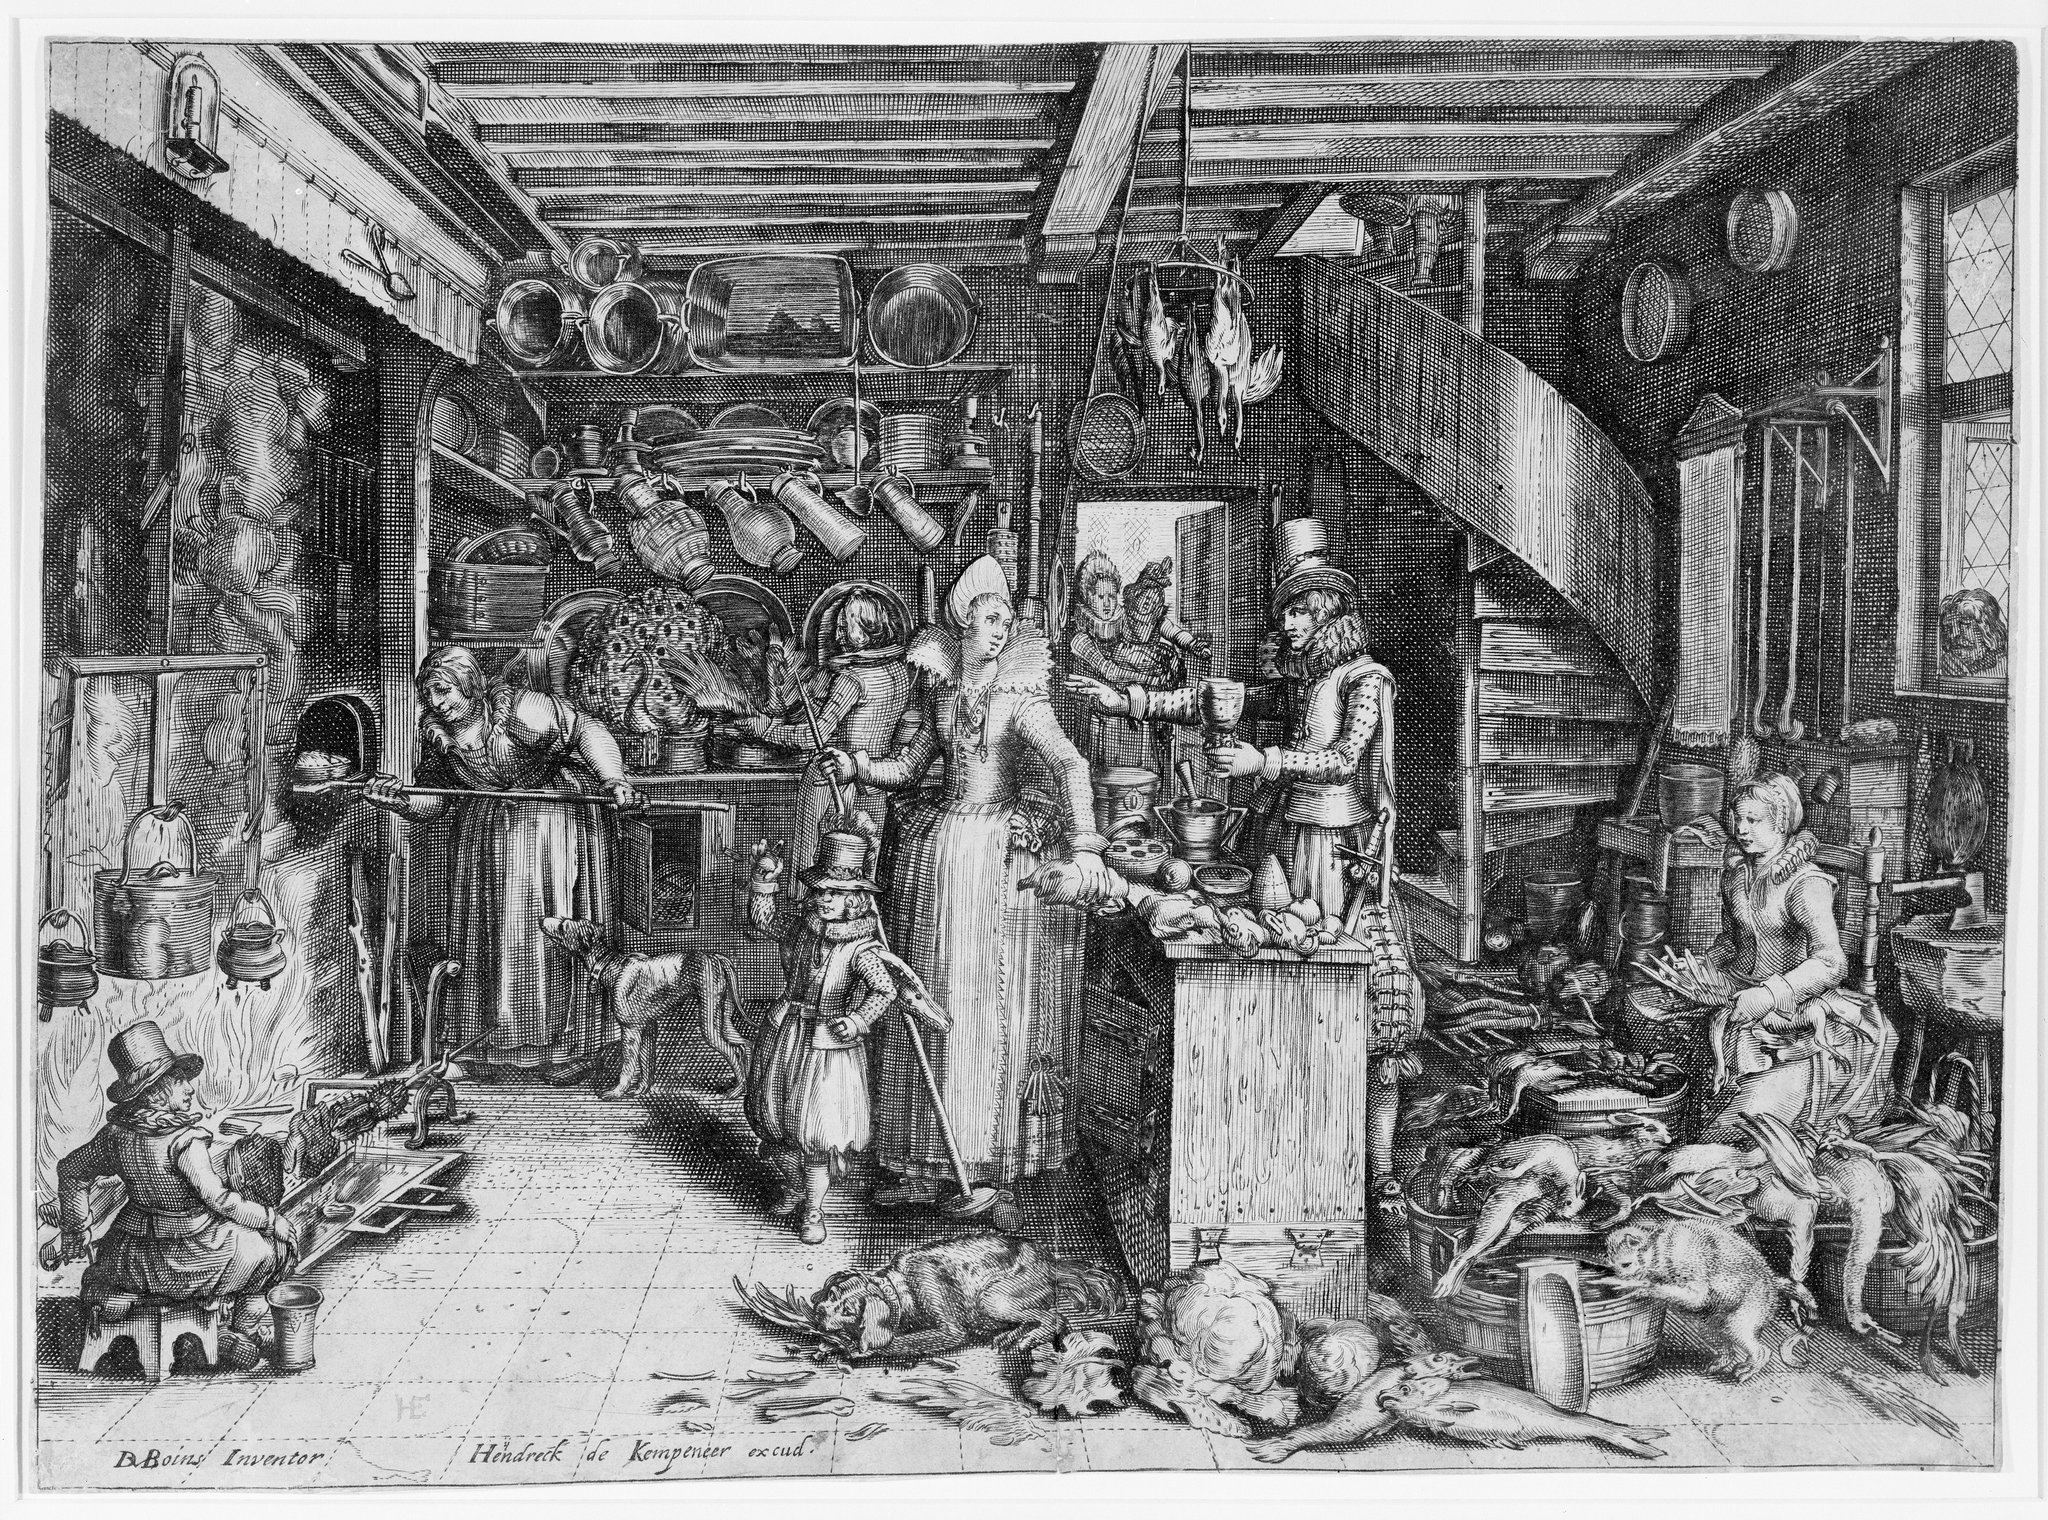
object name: print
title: Kitchen Interior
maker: david vinckboons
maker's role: artist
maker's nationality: netherlandish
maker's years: 1576-1629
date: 1600-1624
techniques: engraving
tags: food,kitchens,girls,men,women,peacocks,dogs